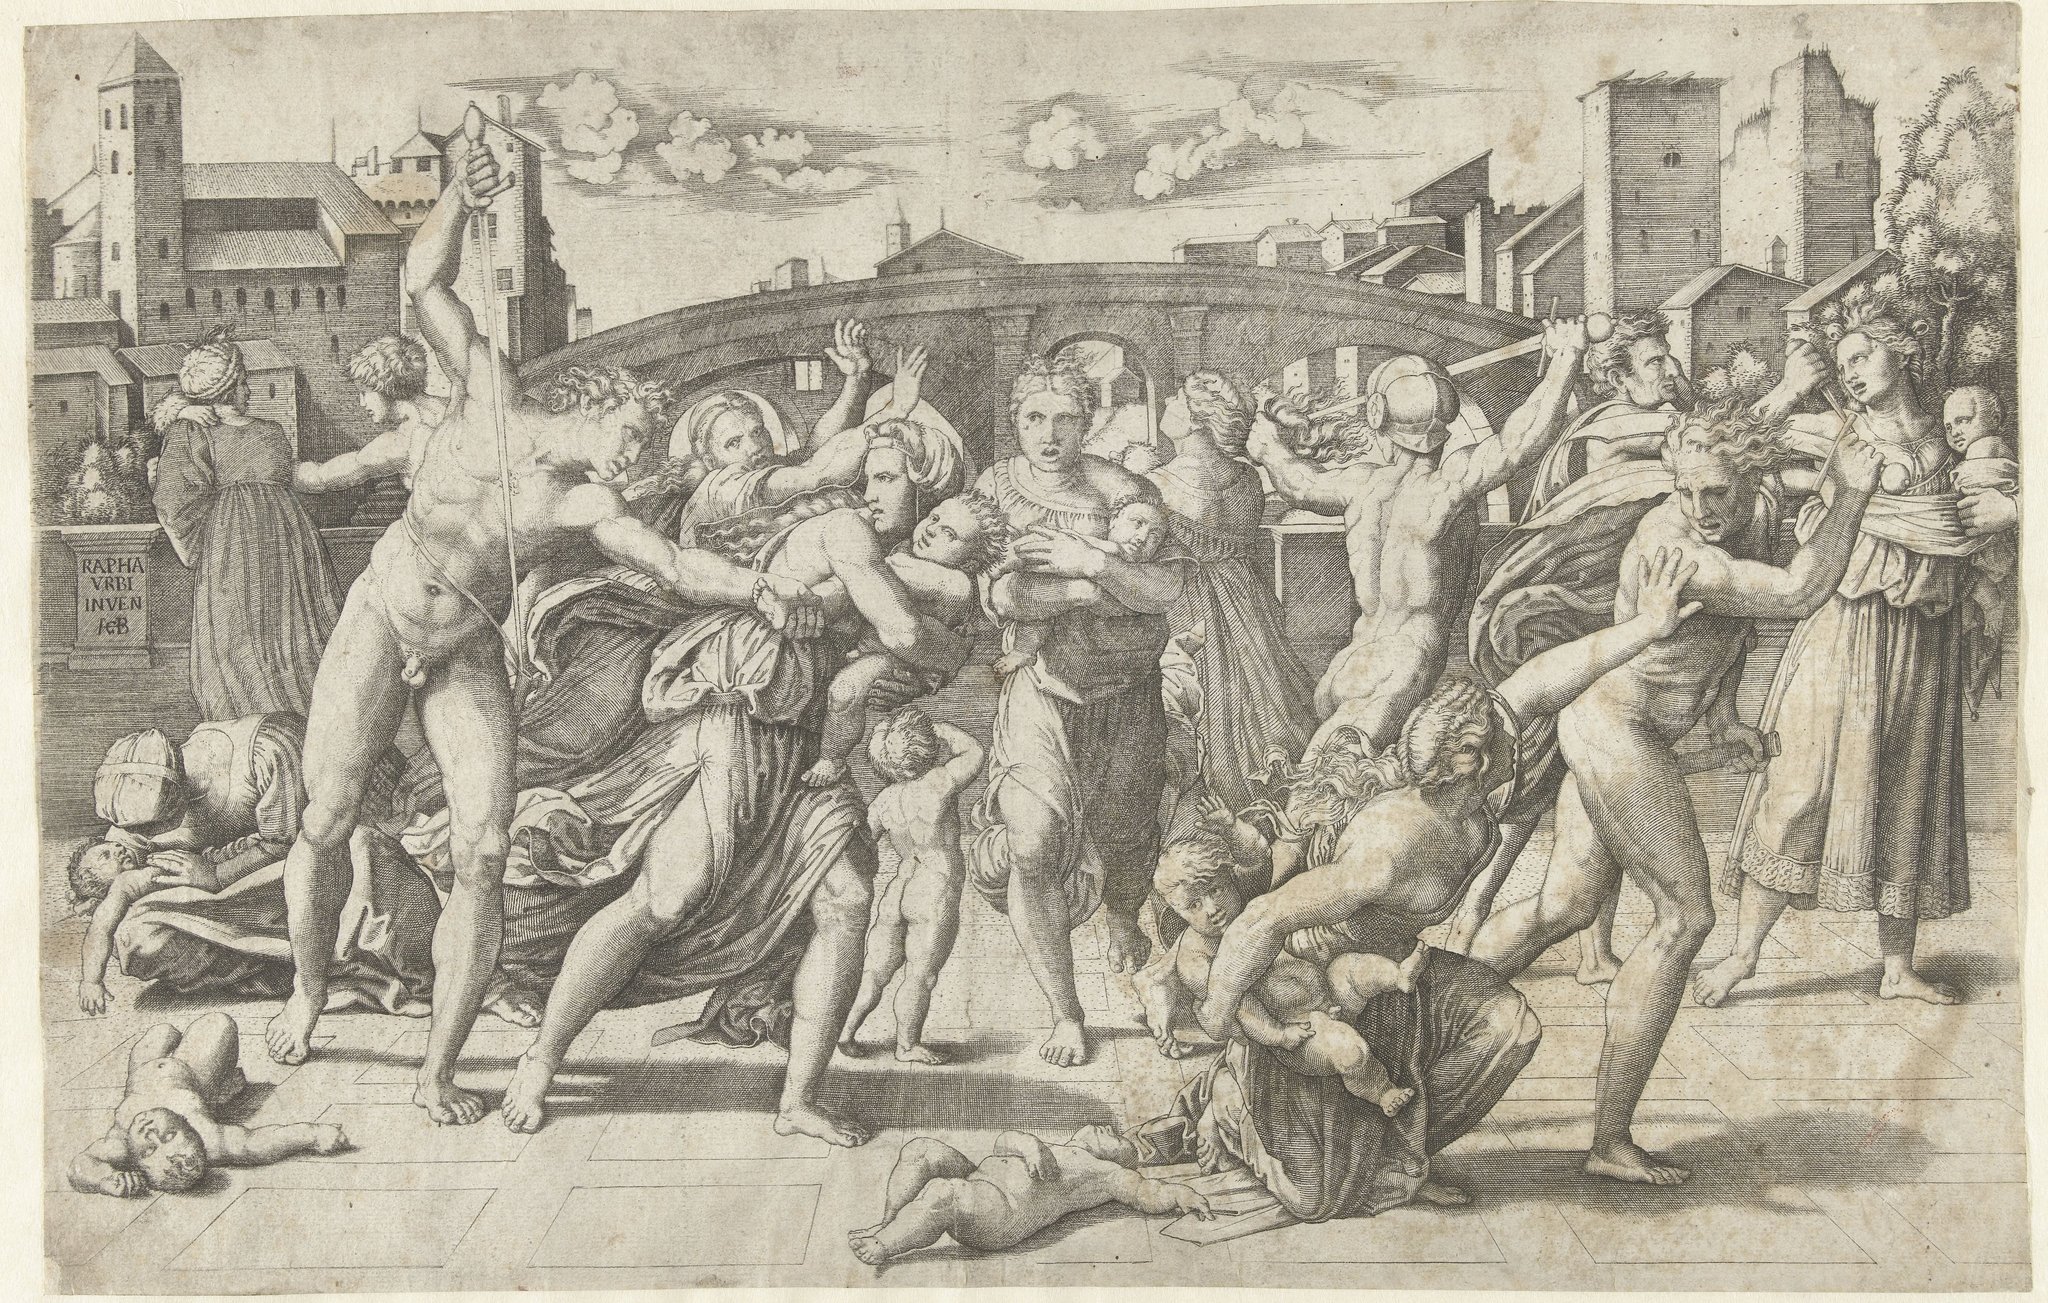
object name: print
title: Kindermoord te Betlehem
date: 1510-1569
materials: paper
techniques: engraving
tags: the massacre of the innocents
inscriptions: collector's mark: Lugt 240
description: Soldaten met getrokken zwaarden doden in opdracht van Herodes kleine kinderen op de binnenplaats van het paleis in Betlehem. Ze trekken de kinderen uit de armen van hun moeders die zich heftig verweren tegen deze aanval. Geheel links buigt een vrouw zich over haar dode kind op schoot.